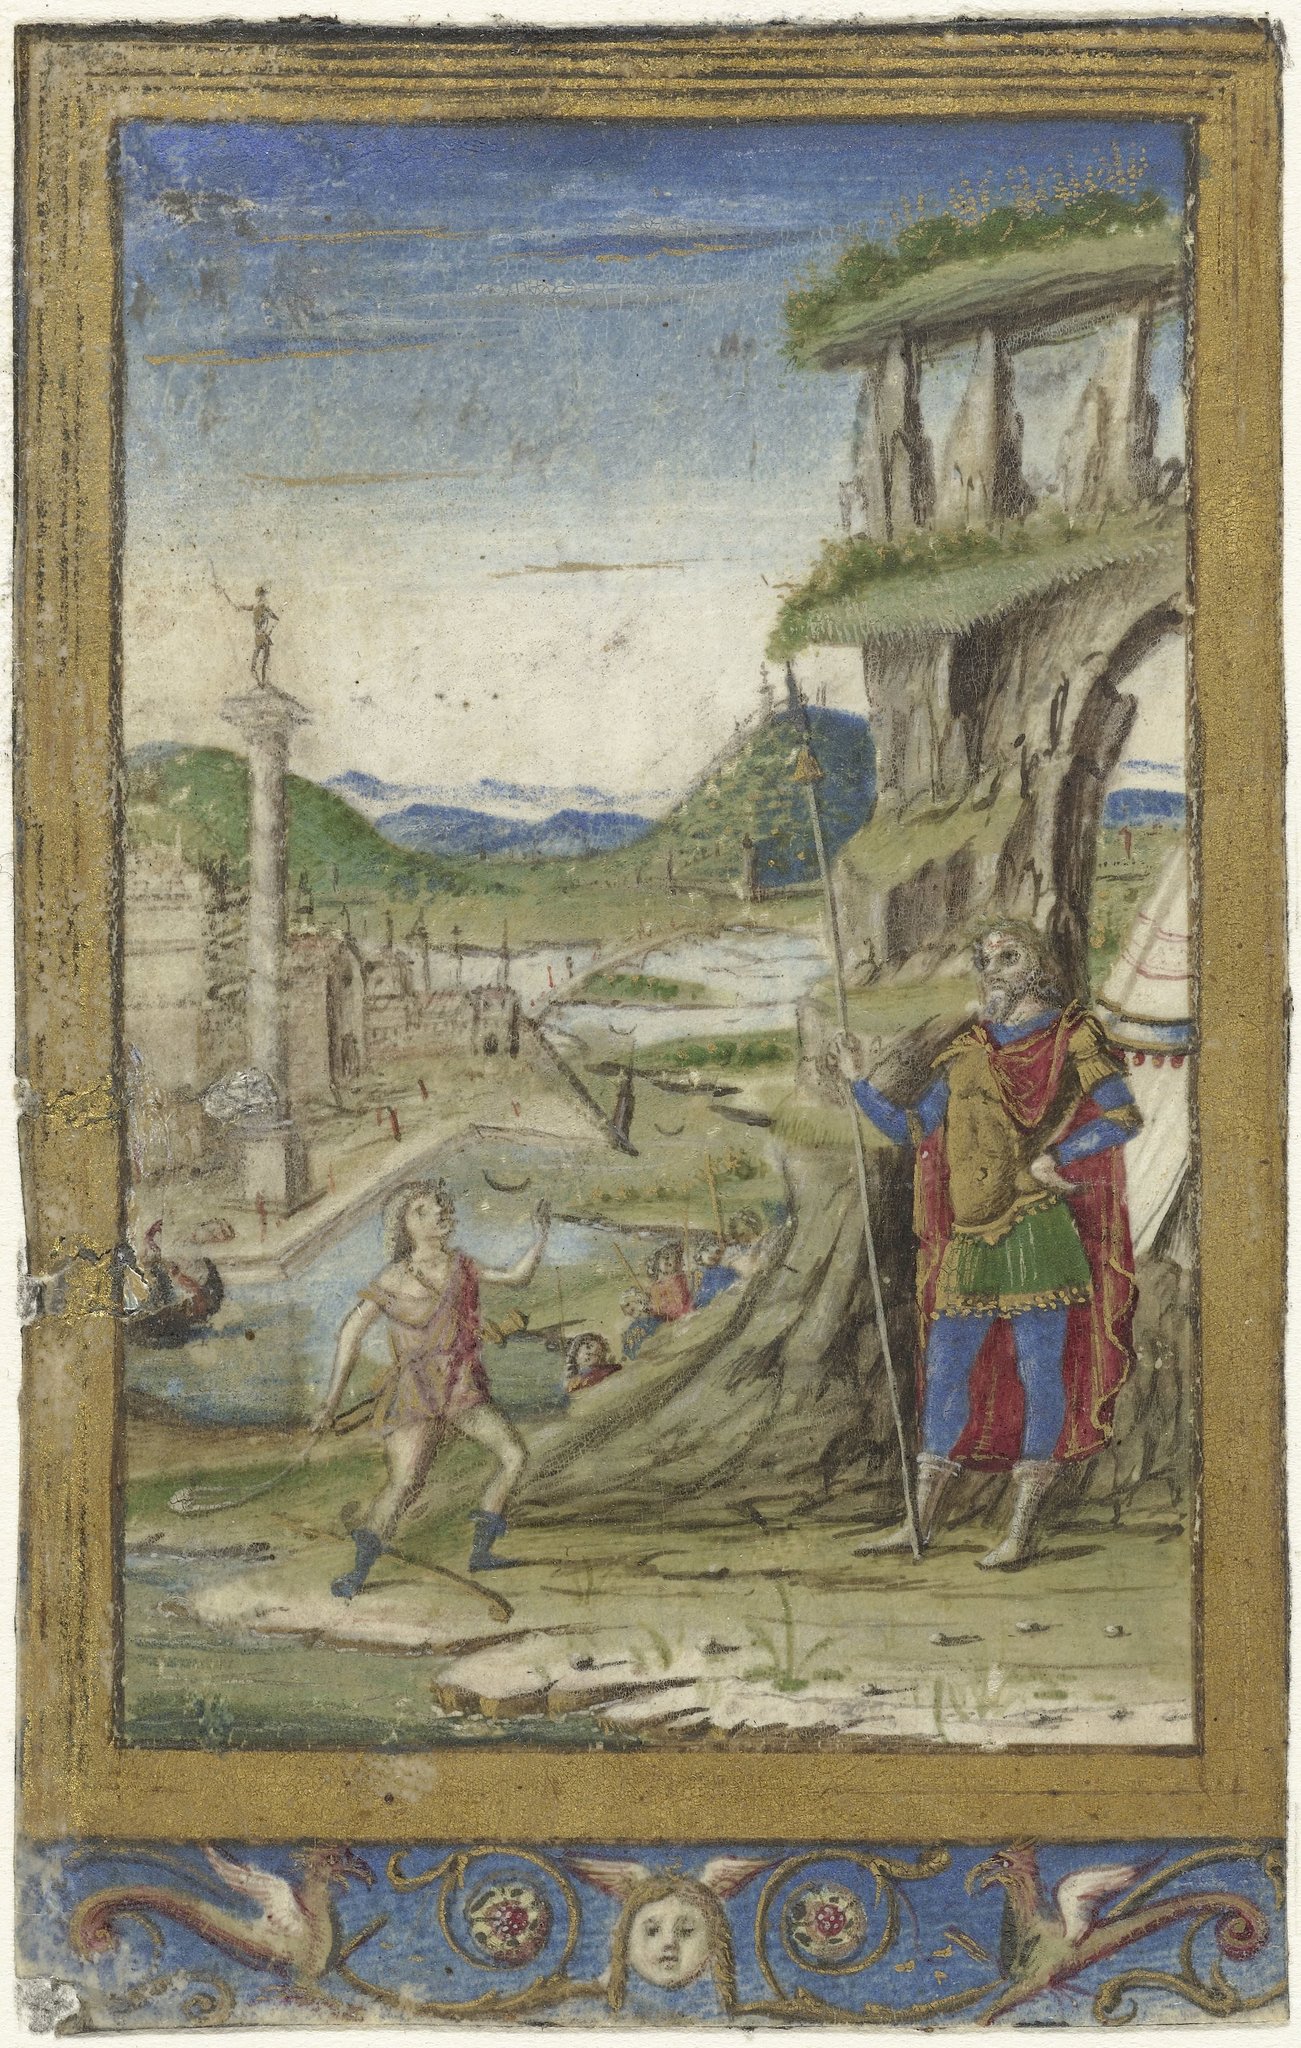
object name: miniature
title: David en Goliath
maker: Anonymous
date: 1490-1550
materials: paint, parchment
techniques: brush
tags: david fighting goliath